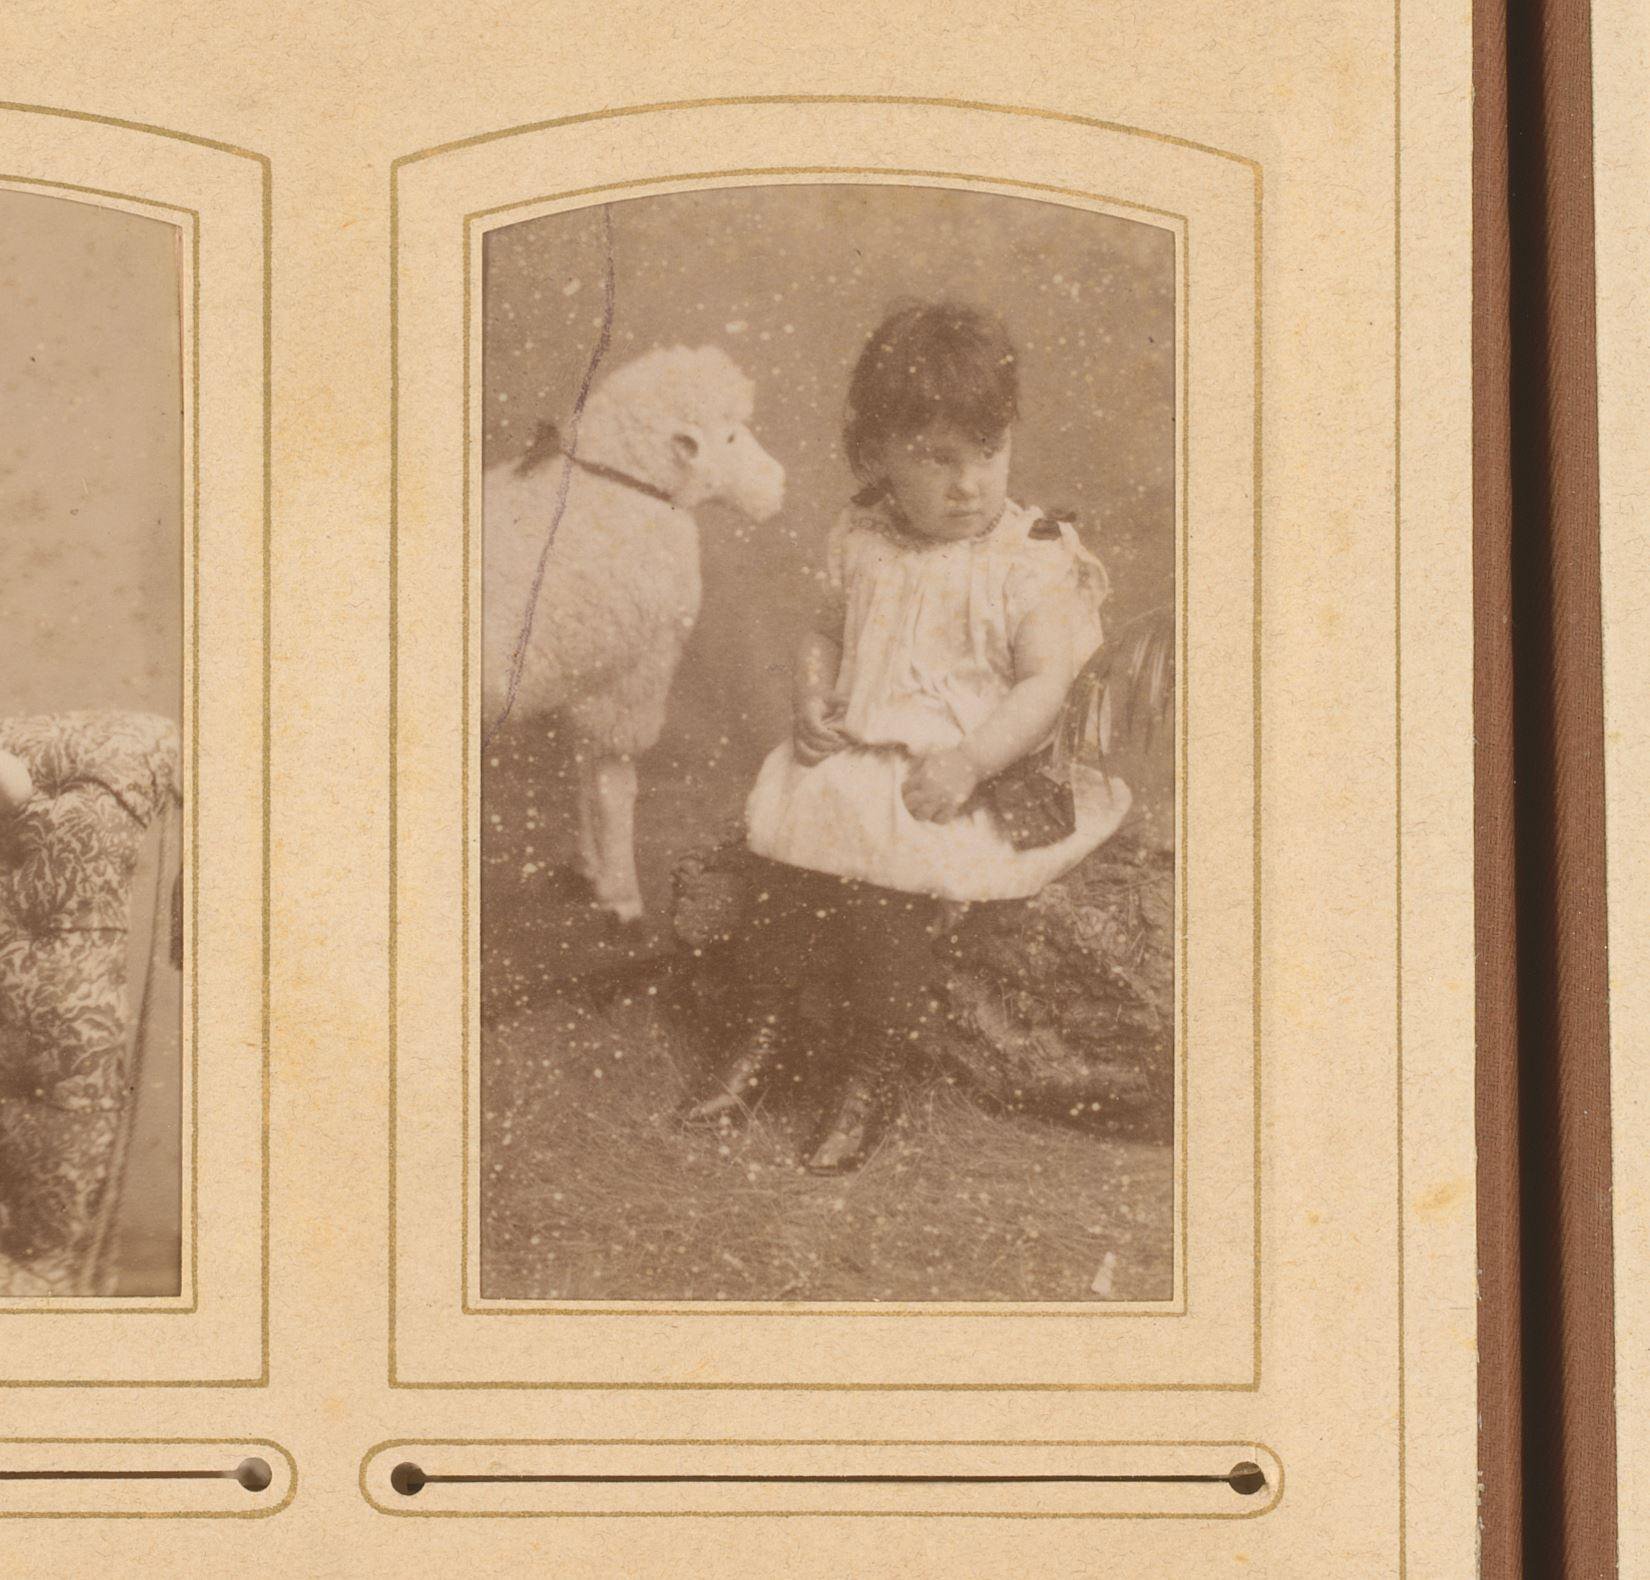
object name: album leaf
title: Portret van een zittende peuter en een speelgoed schaap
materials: cardboard, photographic support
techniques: albumen print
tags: sitting figure - aa - female human figure, historical persons - bb - woman, (playing with) toy animals, toddler (female)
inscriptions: inscription: ‘Bijzondere inrigting voor vergrootingen/ in Kooldruck, Crayon, olieverf, en ge-/ woone phot./ Van alle portretten kunnen steeds na-/ besteld worden./ C. F. Cordes/ Haarlem/ Groote Houtstraat./ 's Bosch/ aan de Parade/ Op verschillende tentoonstellingen bekroond en met de/ groote Koninklijke médaille voor tekening naar 't leven.’